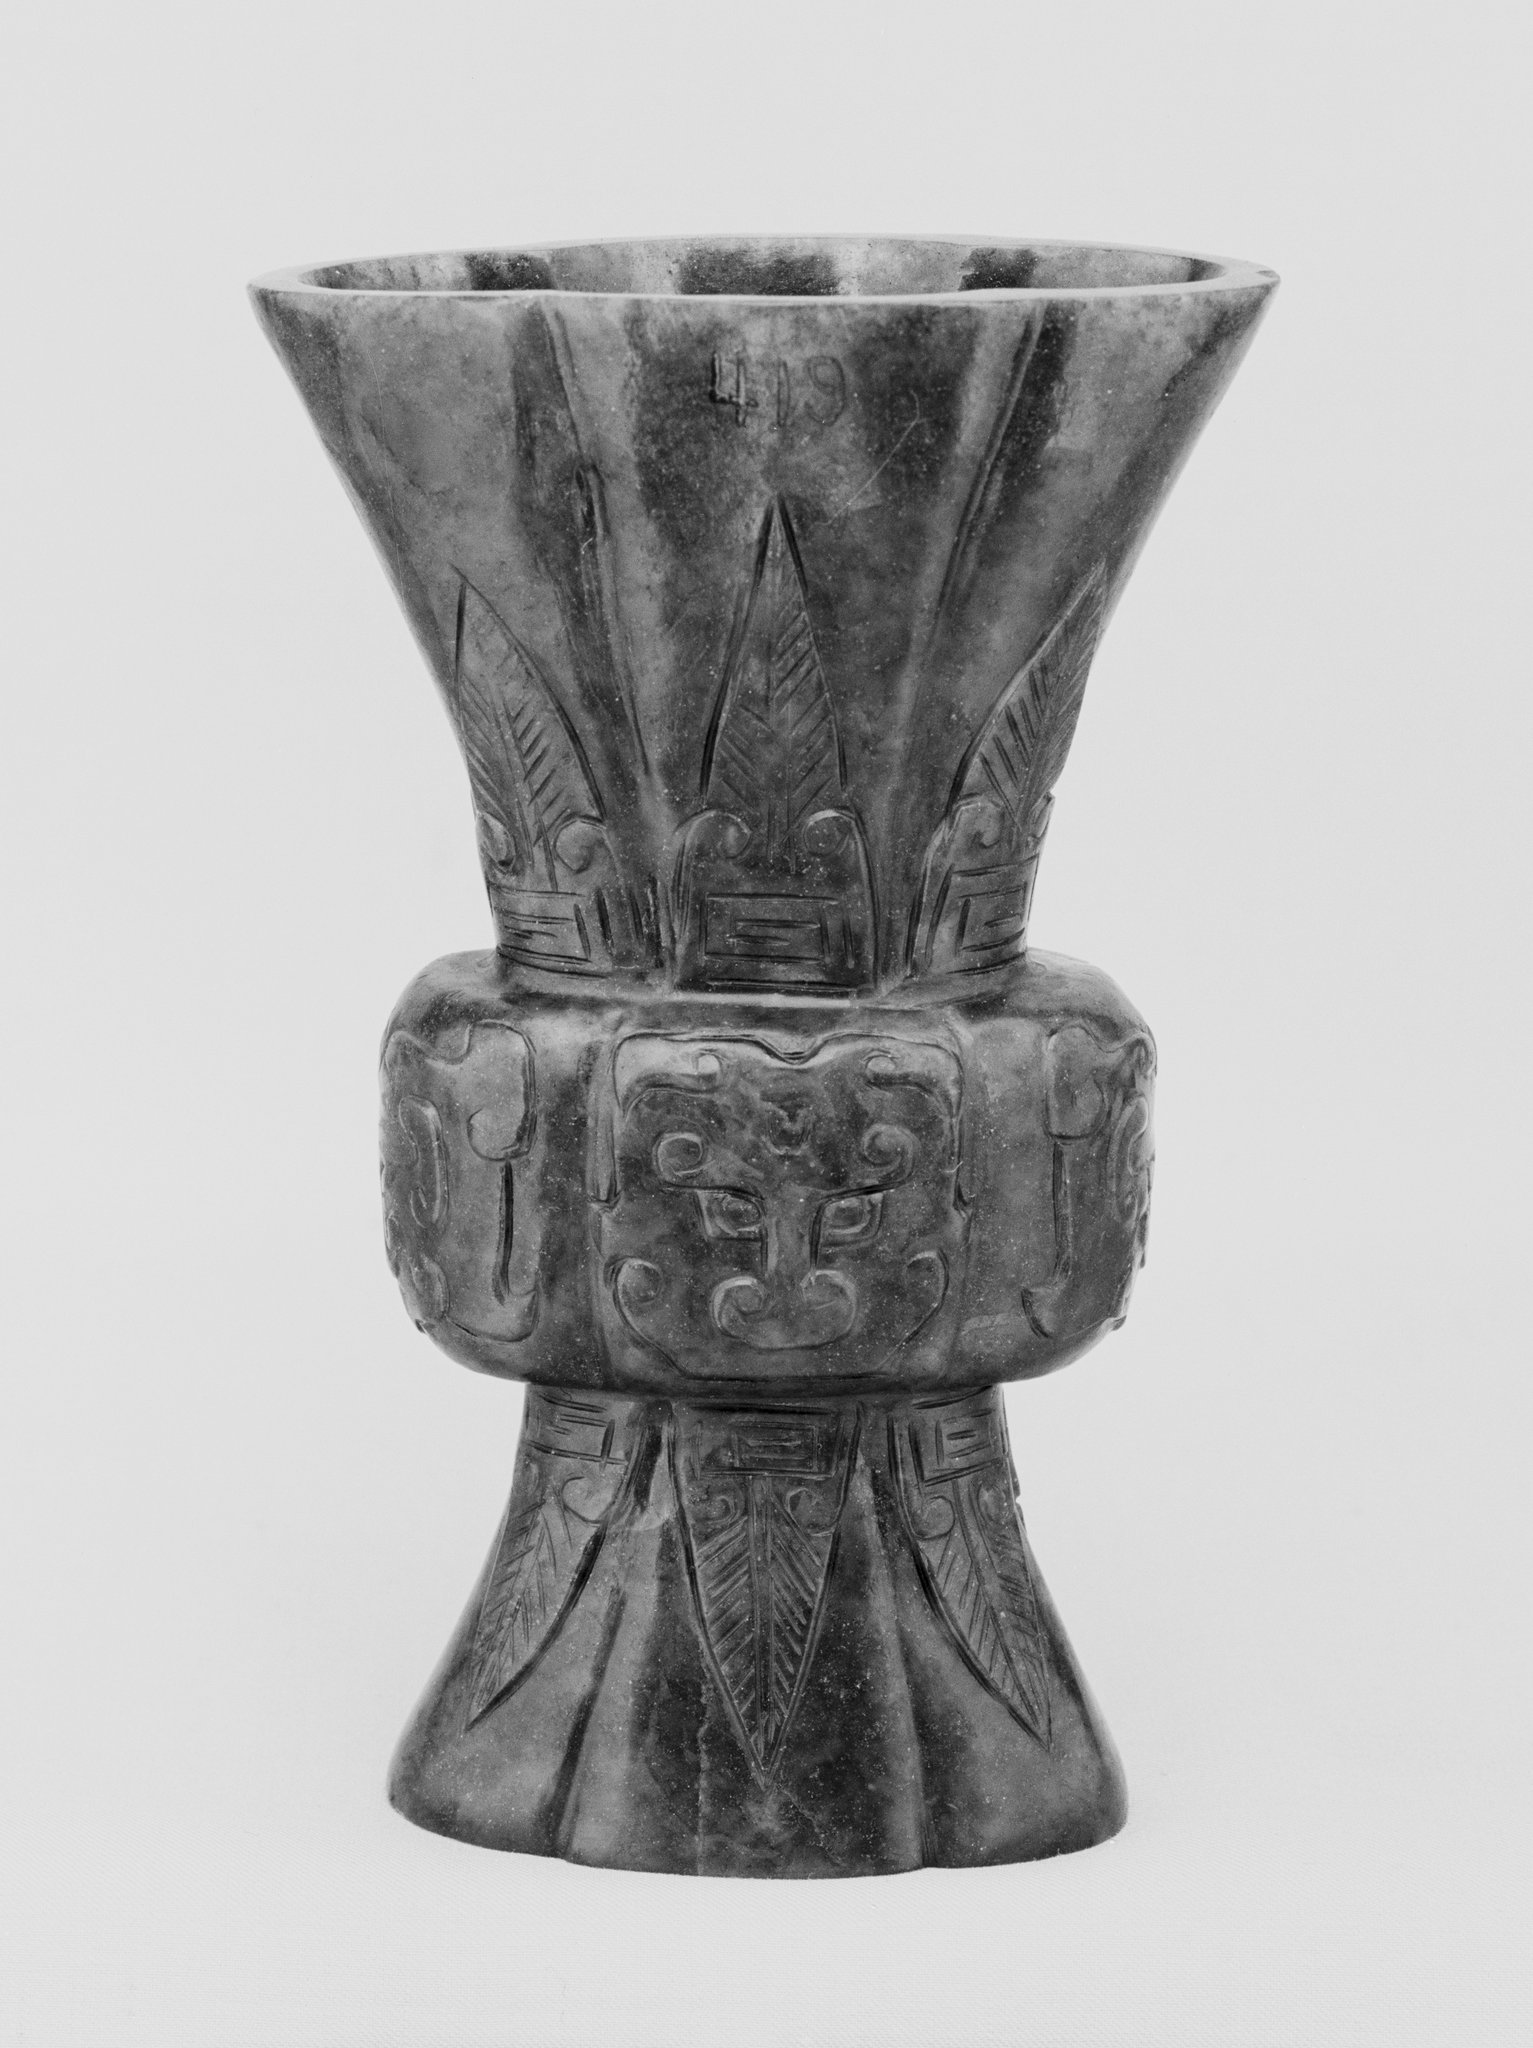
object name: vase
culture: chinese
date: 1368-1644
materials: jade